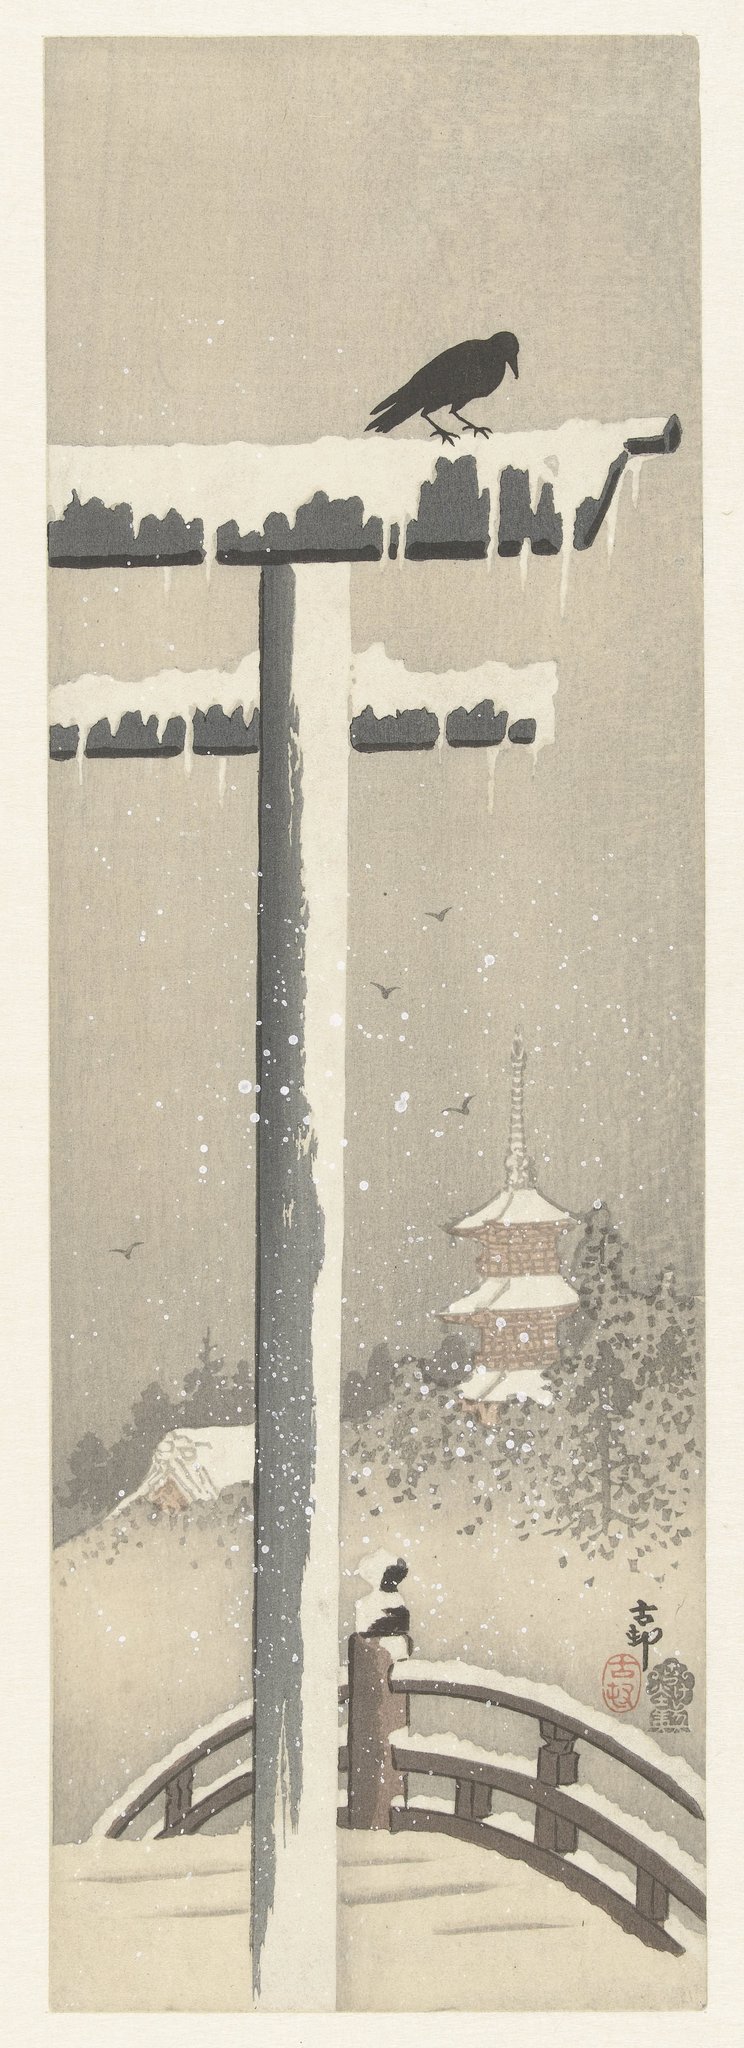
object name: print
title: Torii in de sneeuw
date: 1900-1910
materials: paper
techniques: woodcut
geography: tokyo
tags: song-birds: crow, non-christian religions (including institutions, customs and antiquities)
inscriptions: collector's mark: Lugt 2228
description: Met sneeuw bedekte Japanse tempelpoort (torii), waarop een kraai. In de achtergrond een besneeuwde pagode tussen bomen.